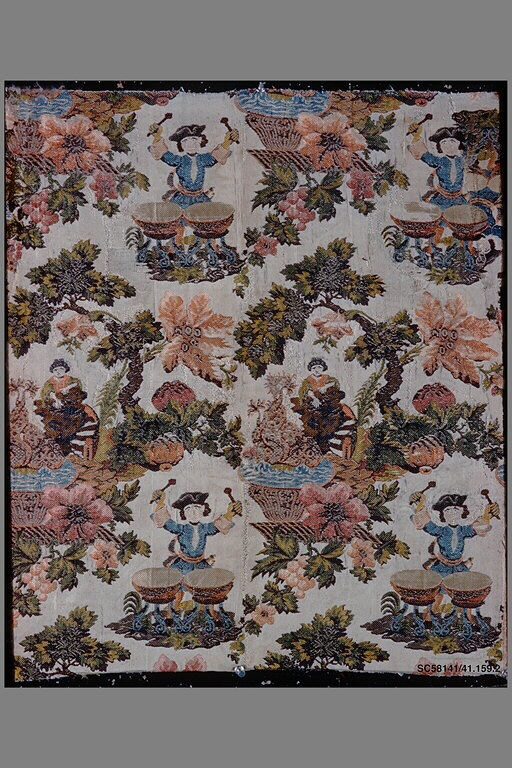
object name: strip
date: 1735-1740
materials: metal thread, silk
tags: human figures,musical instruments,flowers